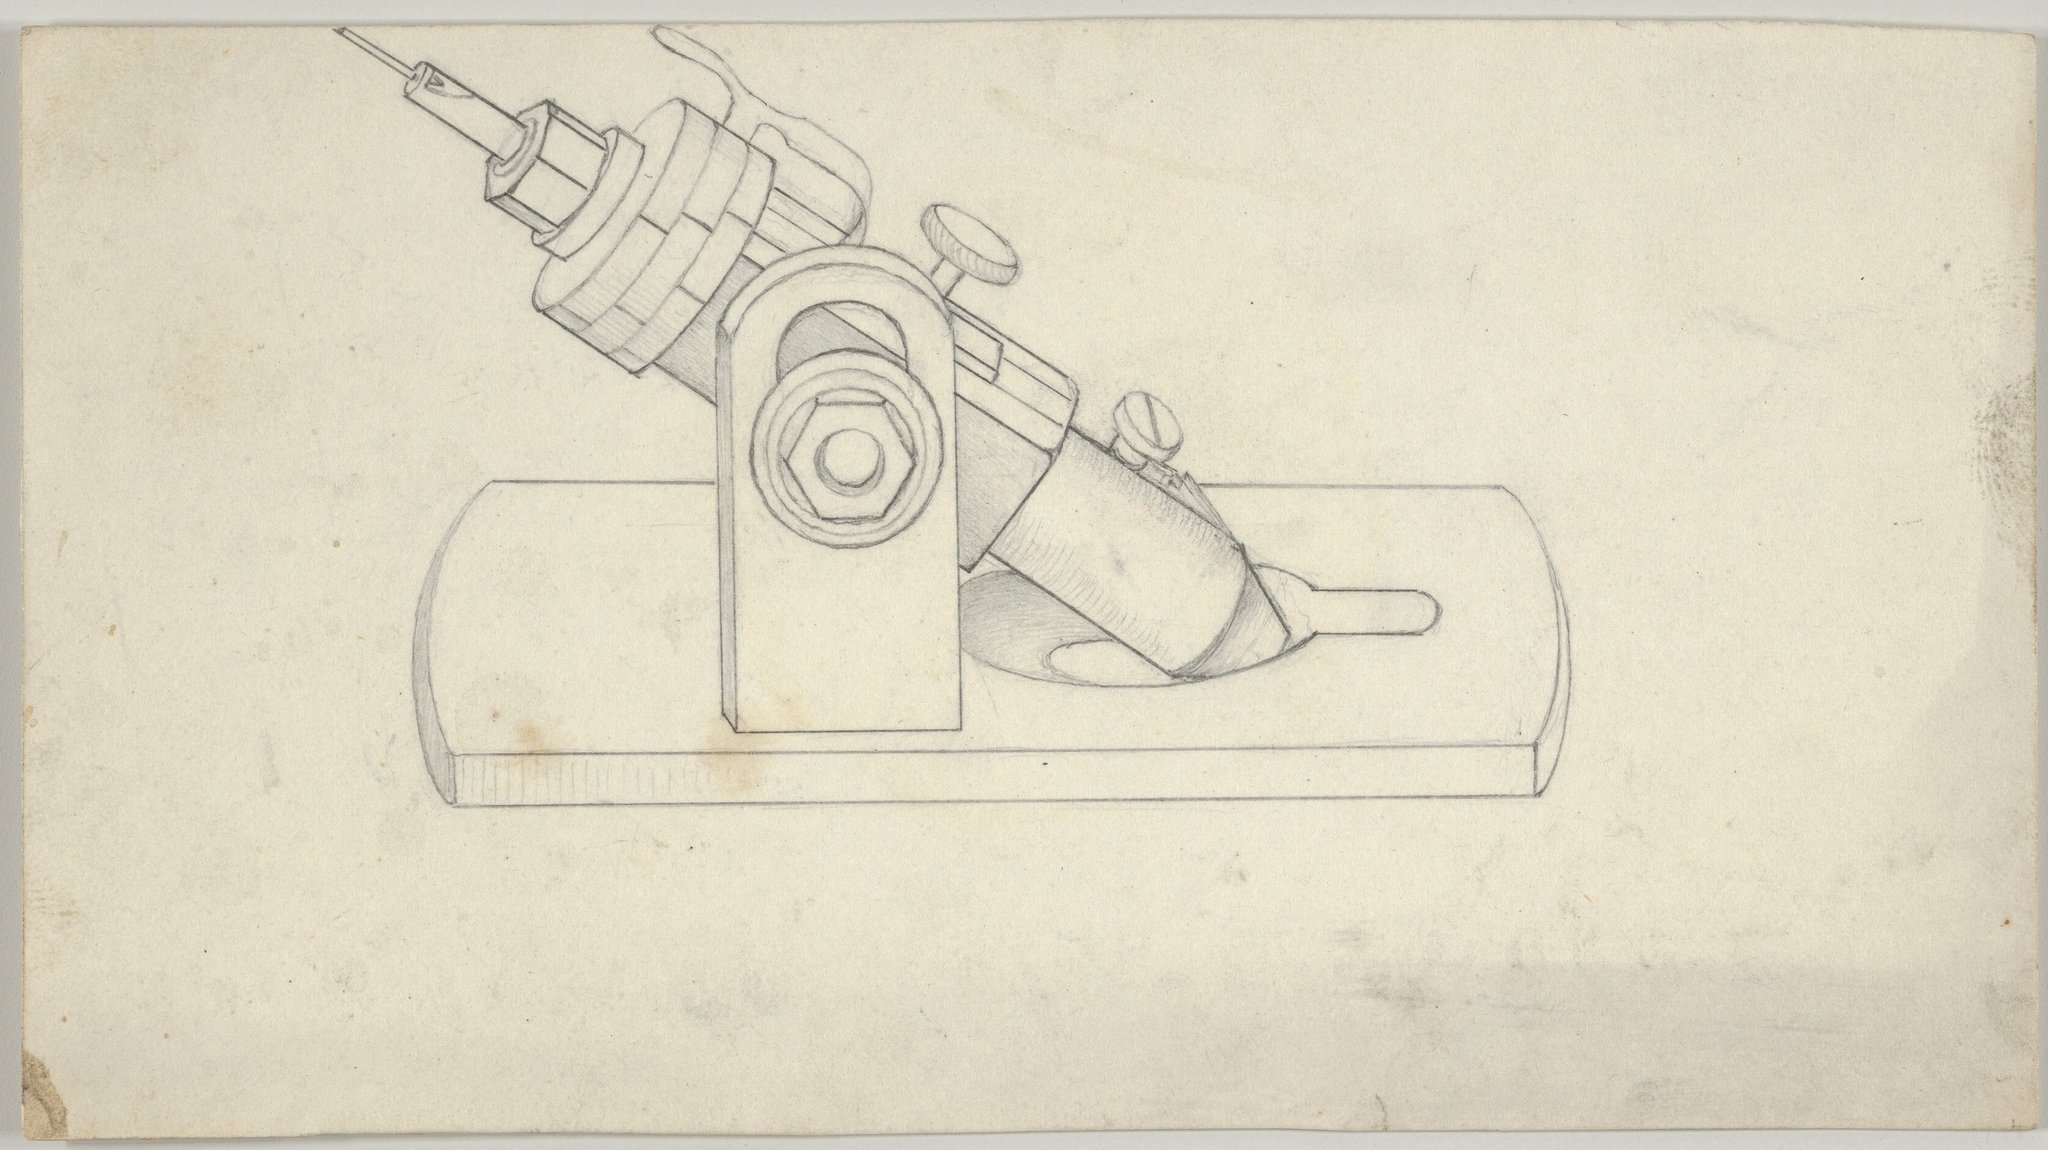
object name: drawing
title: Stylus of a Machine Used for Engraving Bank notes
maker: cyrus durand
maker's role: artist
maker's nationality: american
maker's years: 1787-1868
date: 1801-1900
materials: graphite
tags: machines